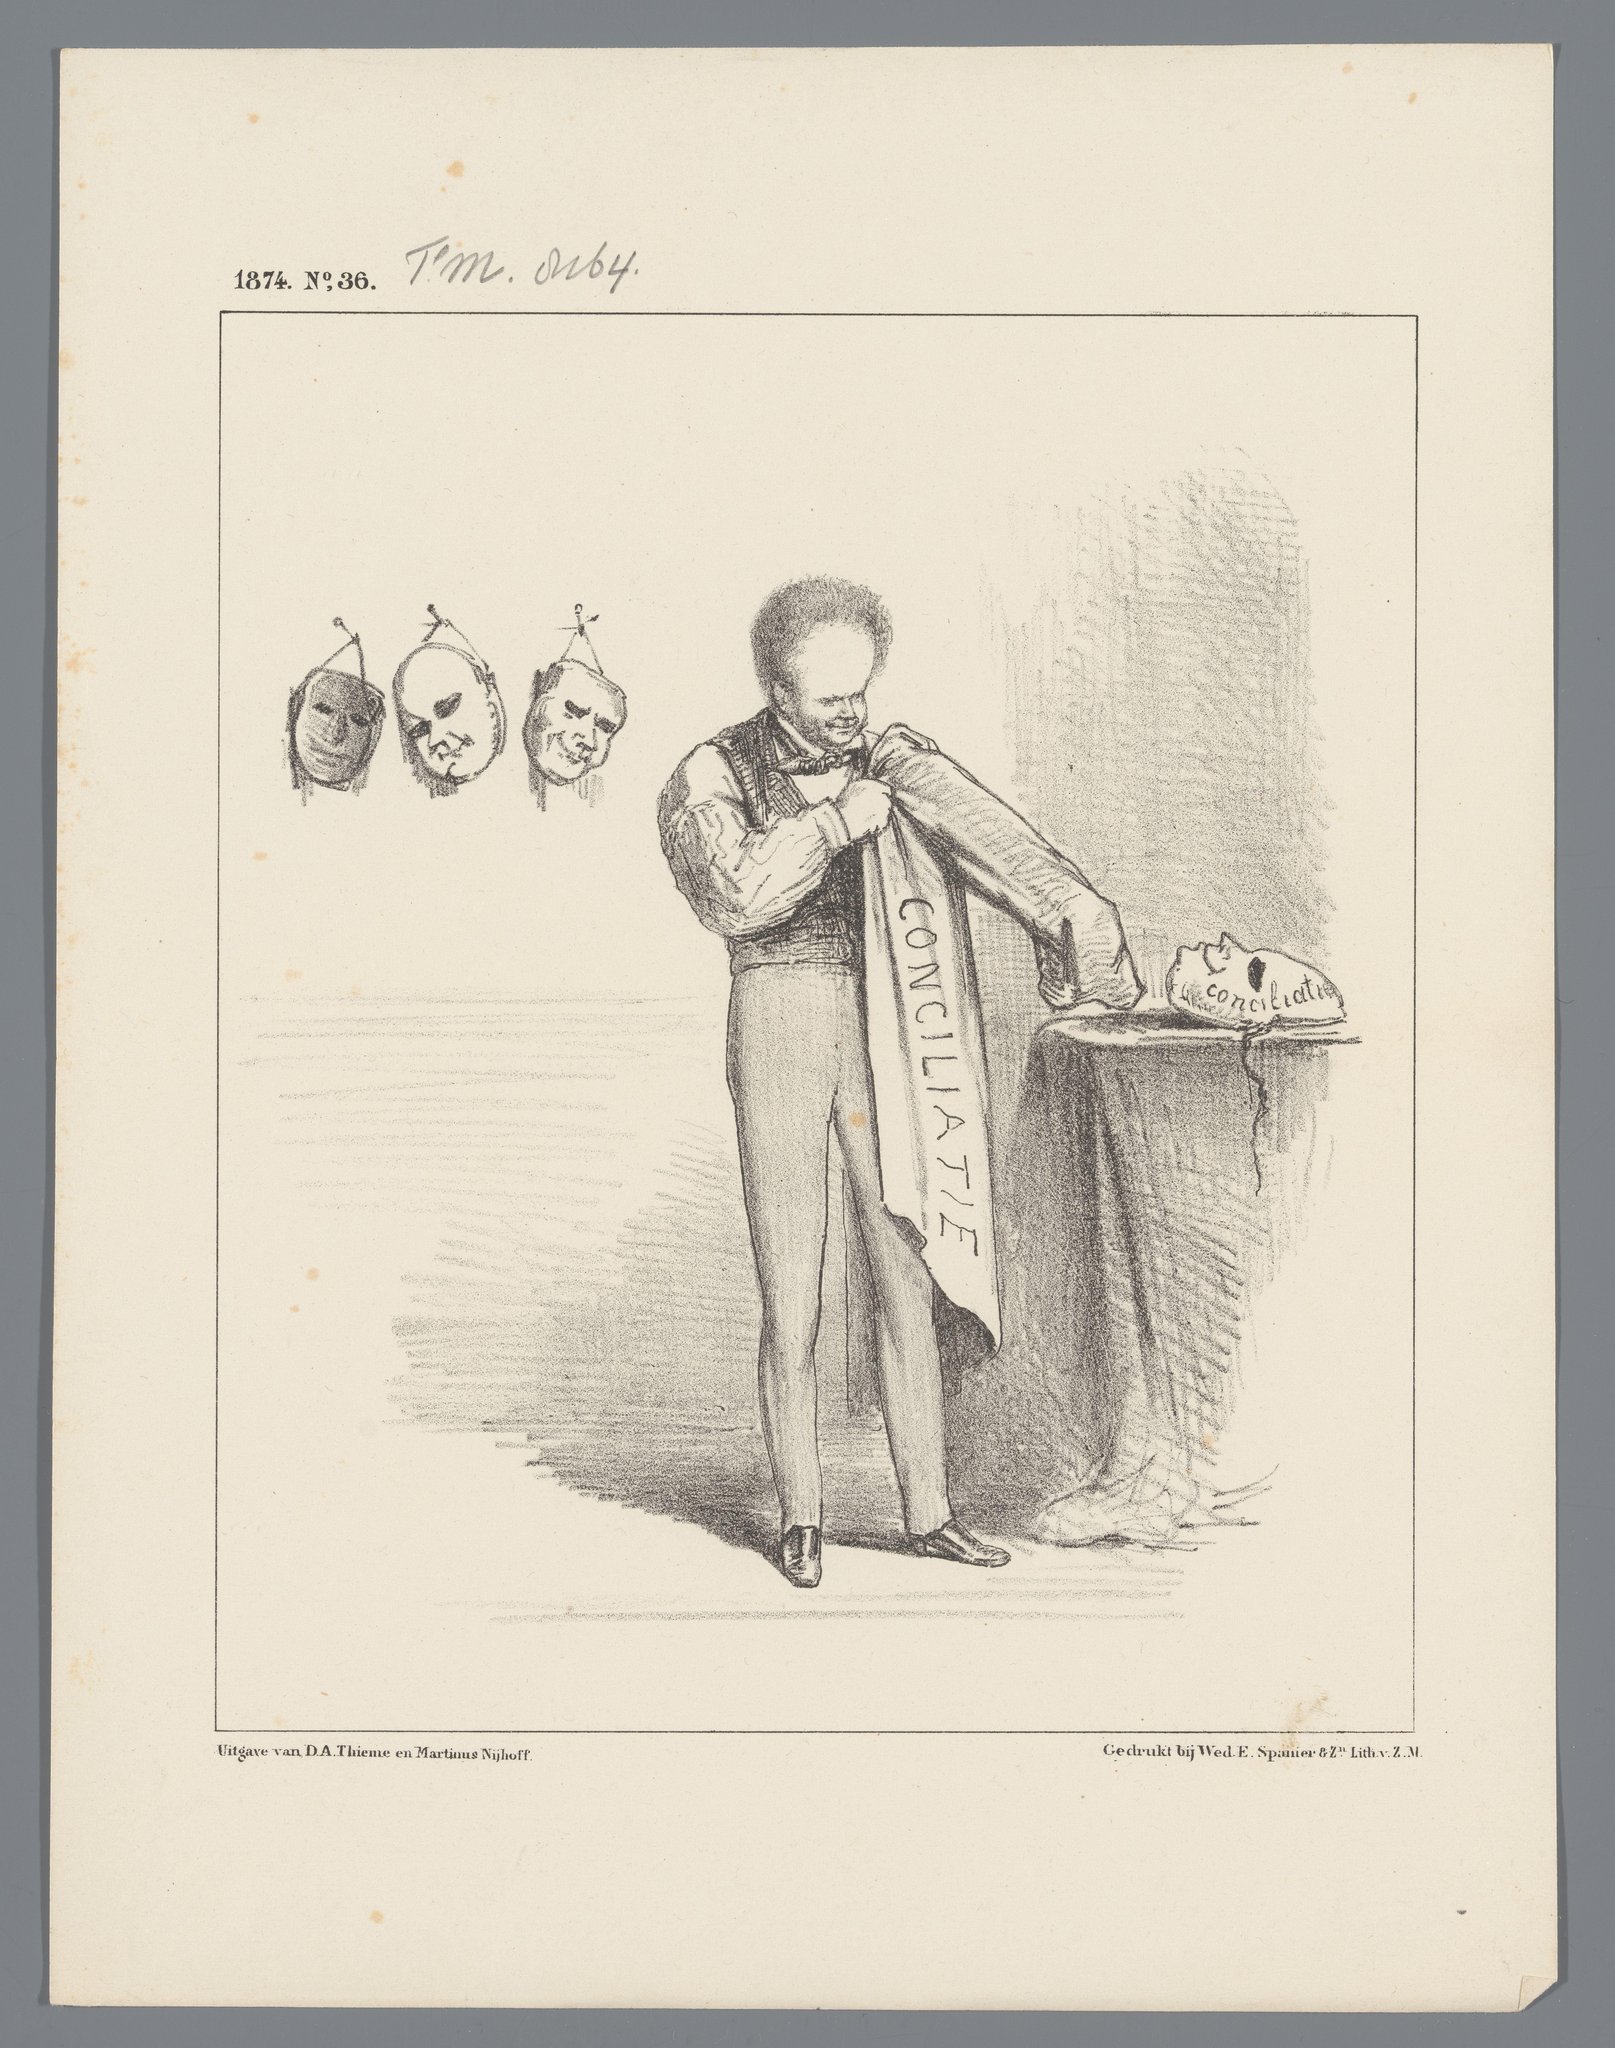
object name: cartoon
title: Spotprent op de verzoenende houding van het Ministerie Heemskerk, 1874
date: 1874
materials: paper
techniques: lithograph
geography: arnhem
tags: amsterdam, the hague, politician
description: Spotprent op de verzoenende houding van het Ministerie Heemskerk, 1874. Plaat verschenen bij het weekblad De Nederlandsche Spectator, nr. 36, 1874.